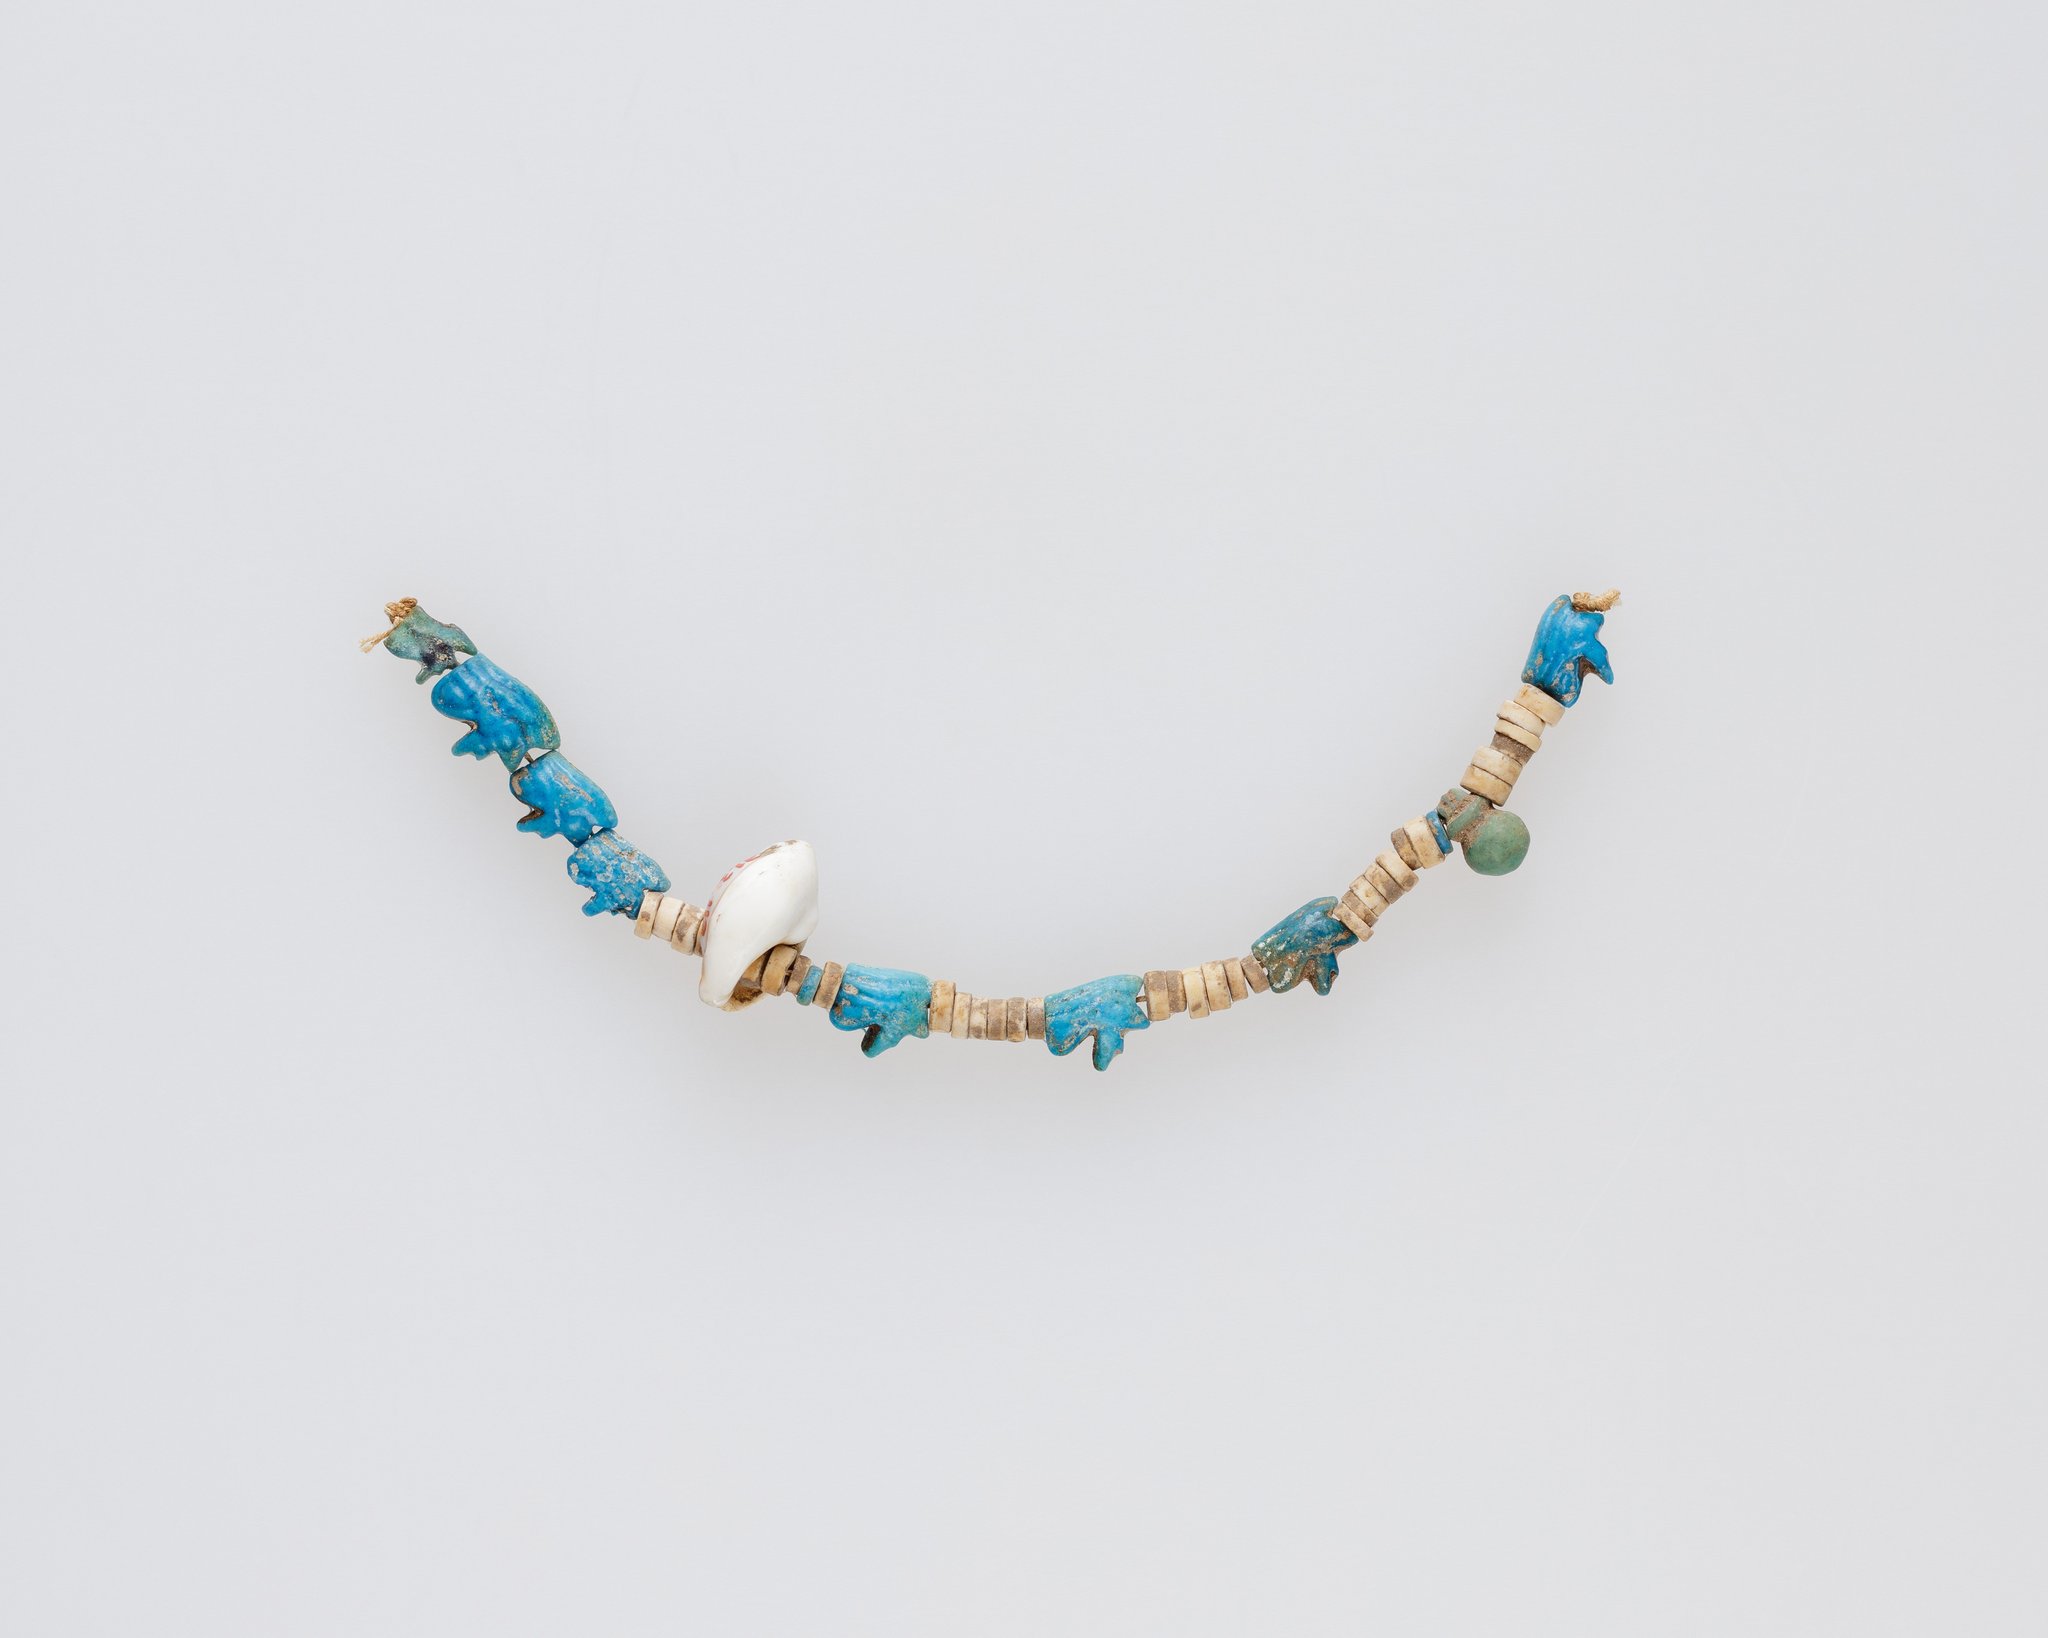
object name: necklace, bead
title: String of beads and amulets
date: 1070-343 BCE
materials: bone, faience, shell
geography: egypt